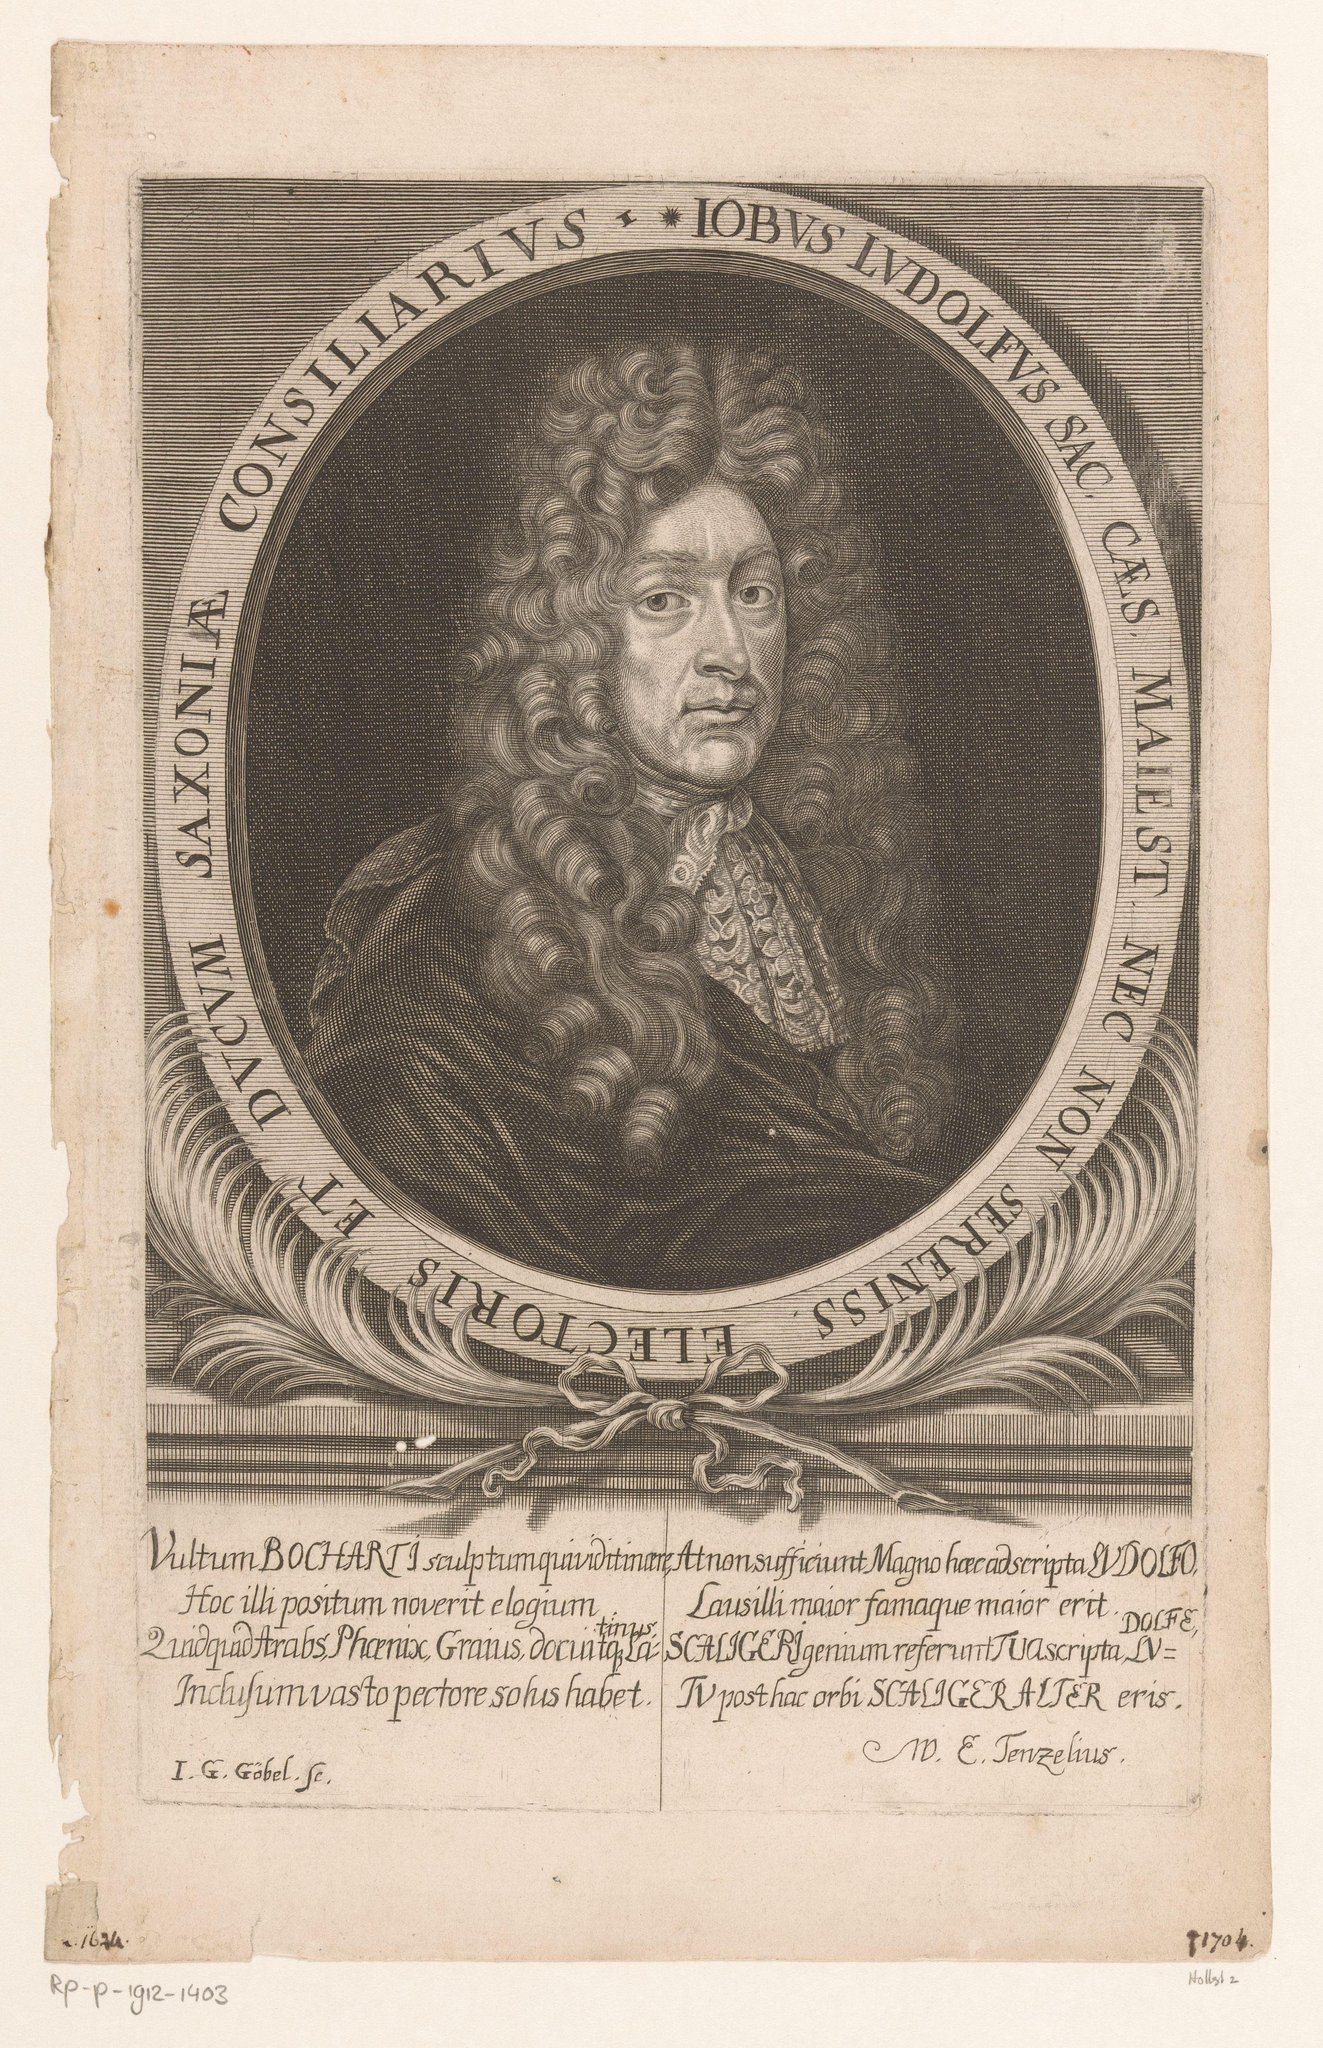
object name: print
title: Portret van Hiob Ludolf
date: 1671-1704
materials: paper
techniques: engraving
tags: trees: palm-tree (+ branch, stick), philology, historical persons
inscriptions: collector's mark: Lugt 2228